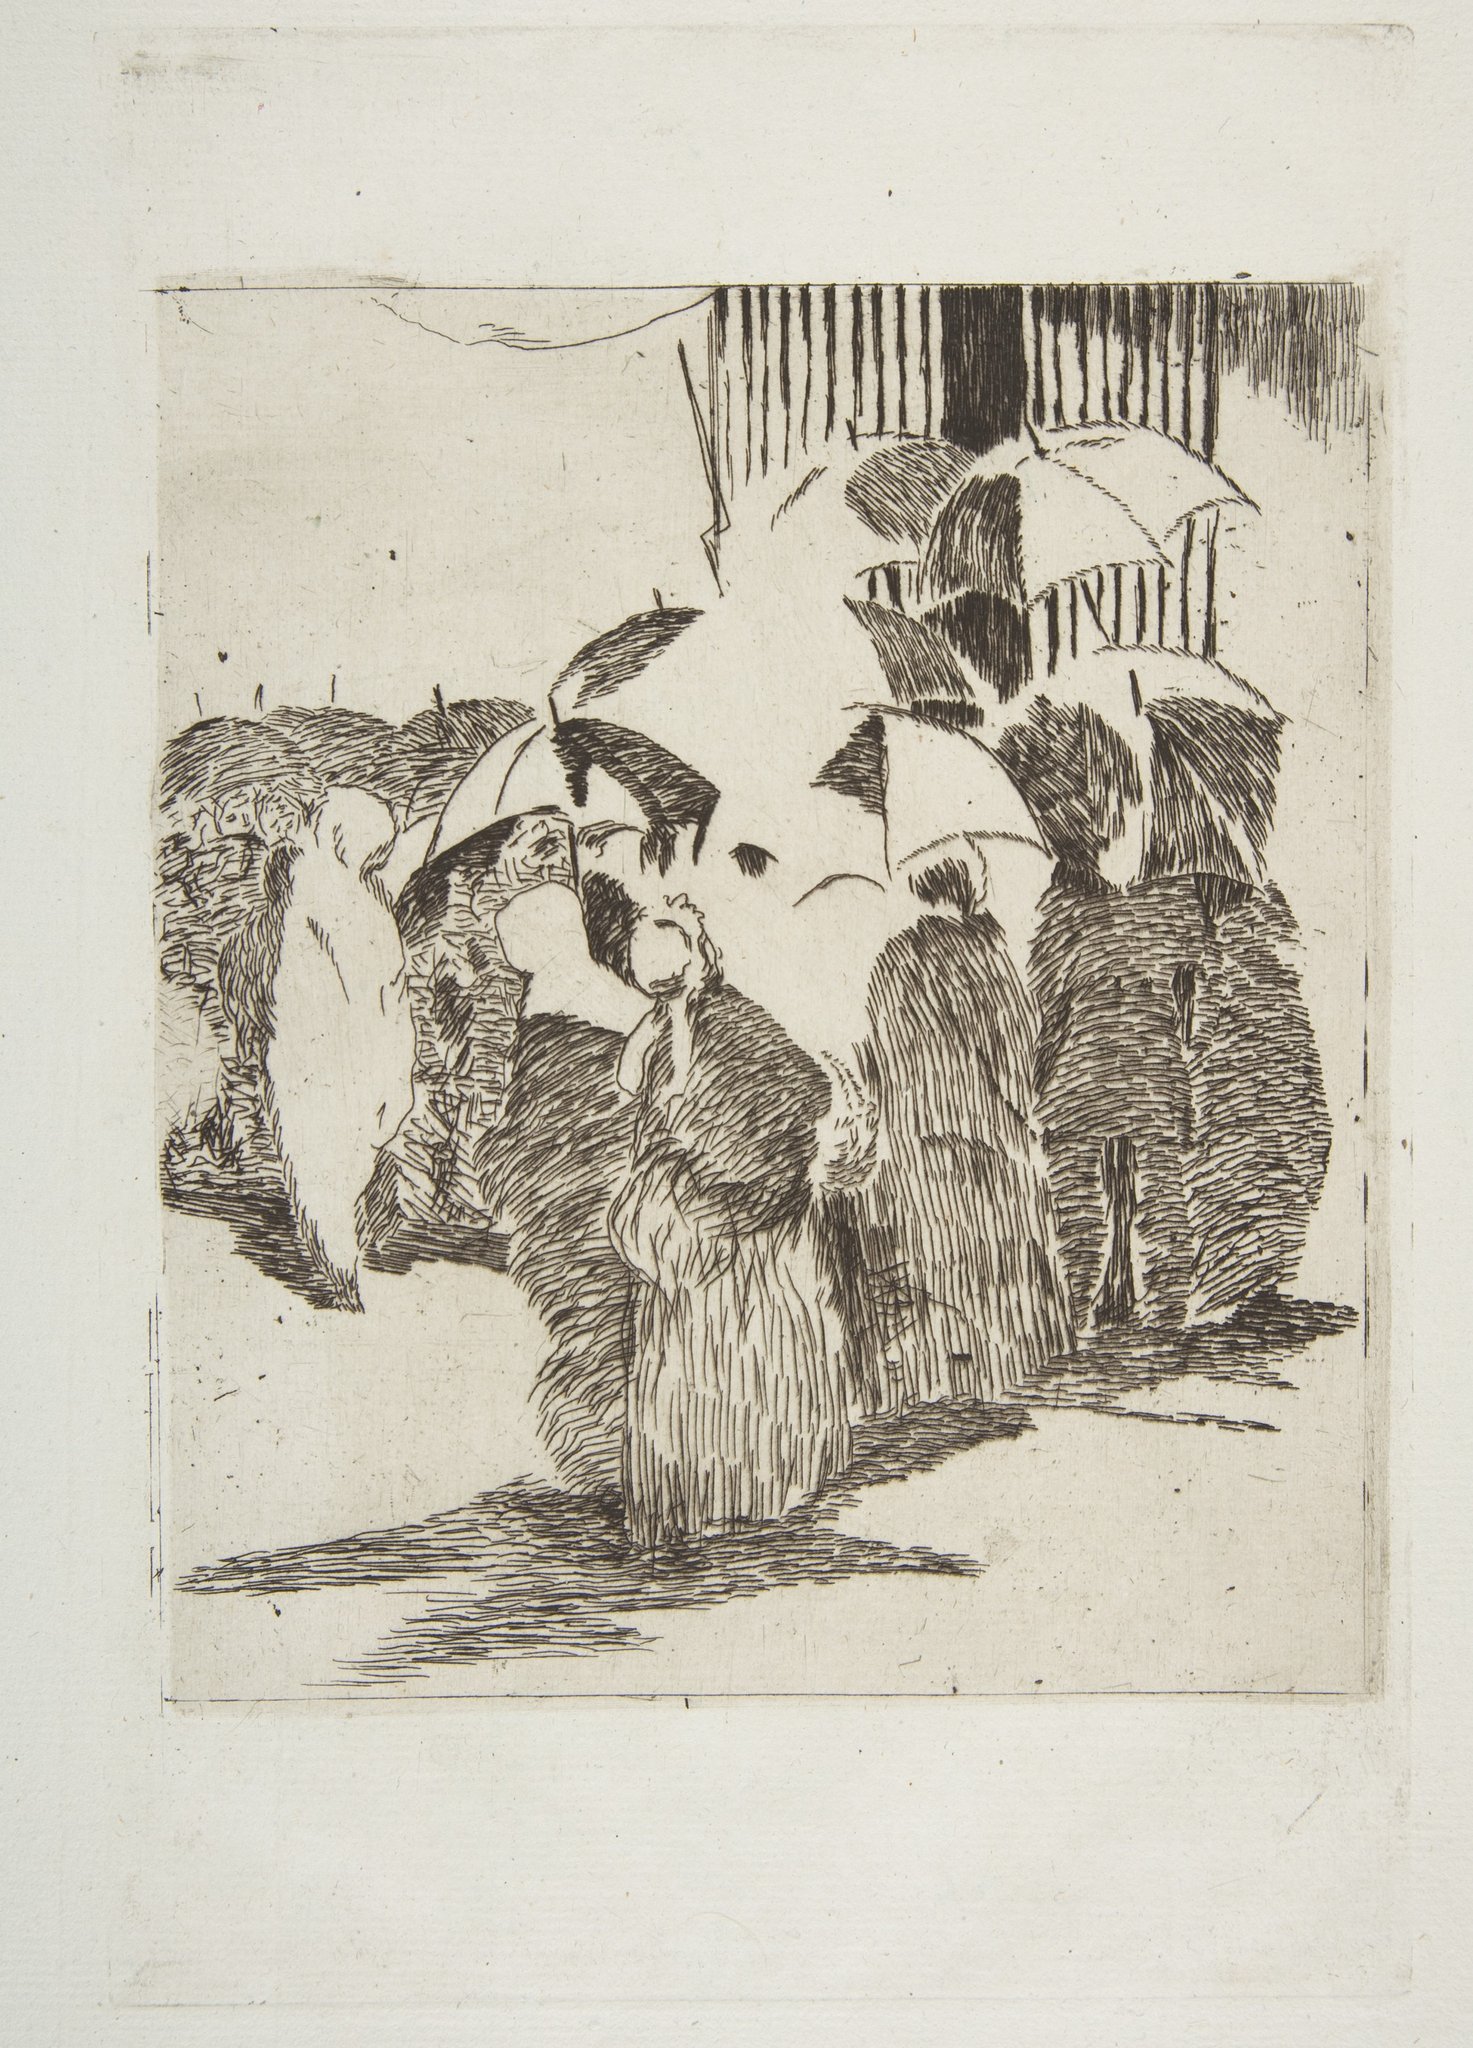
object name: print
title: Line in front of the Butcher Shop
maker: édouard manet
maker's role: artist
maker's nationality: french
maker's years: 1832-1883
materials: paper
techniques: etching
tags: crowd,umbrellas